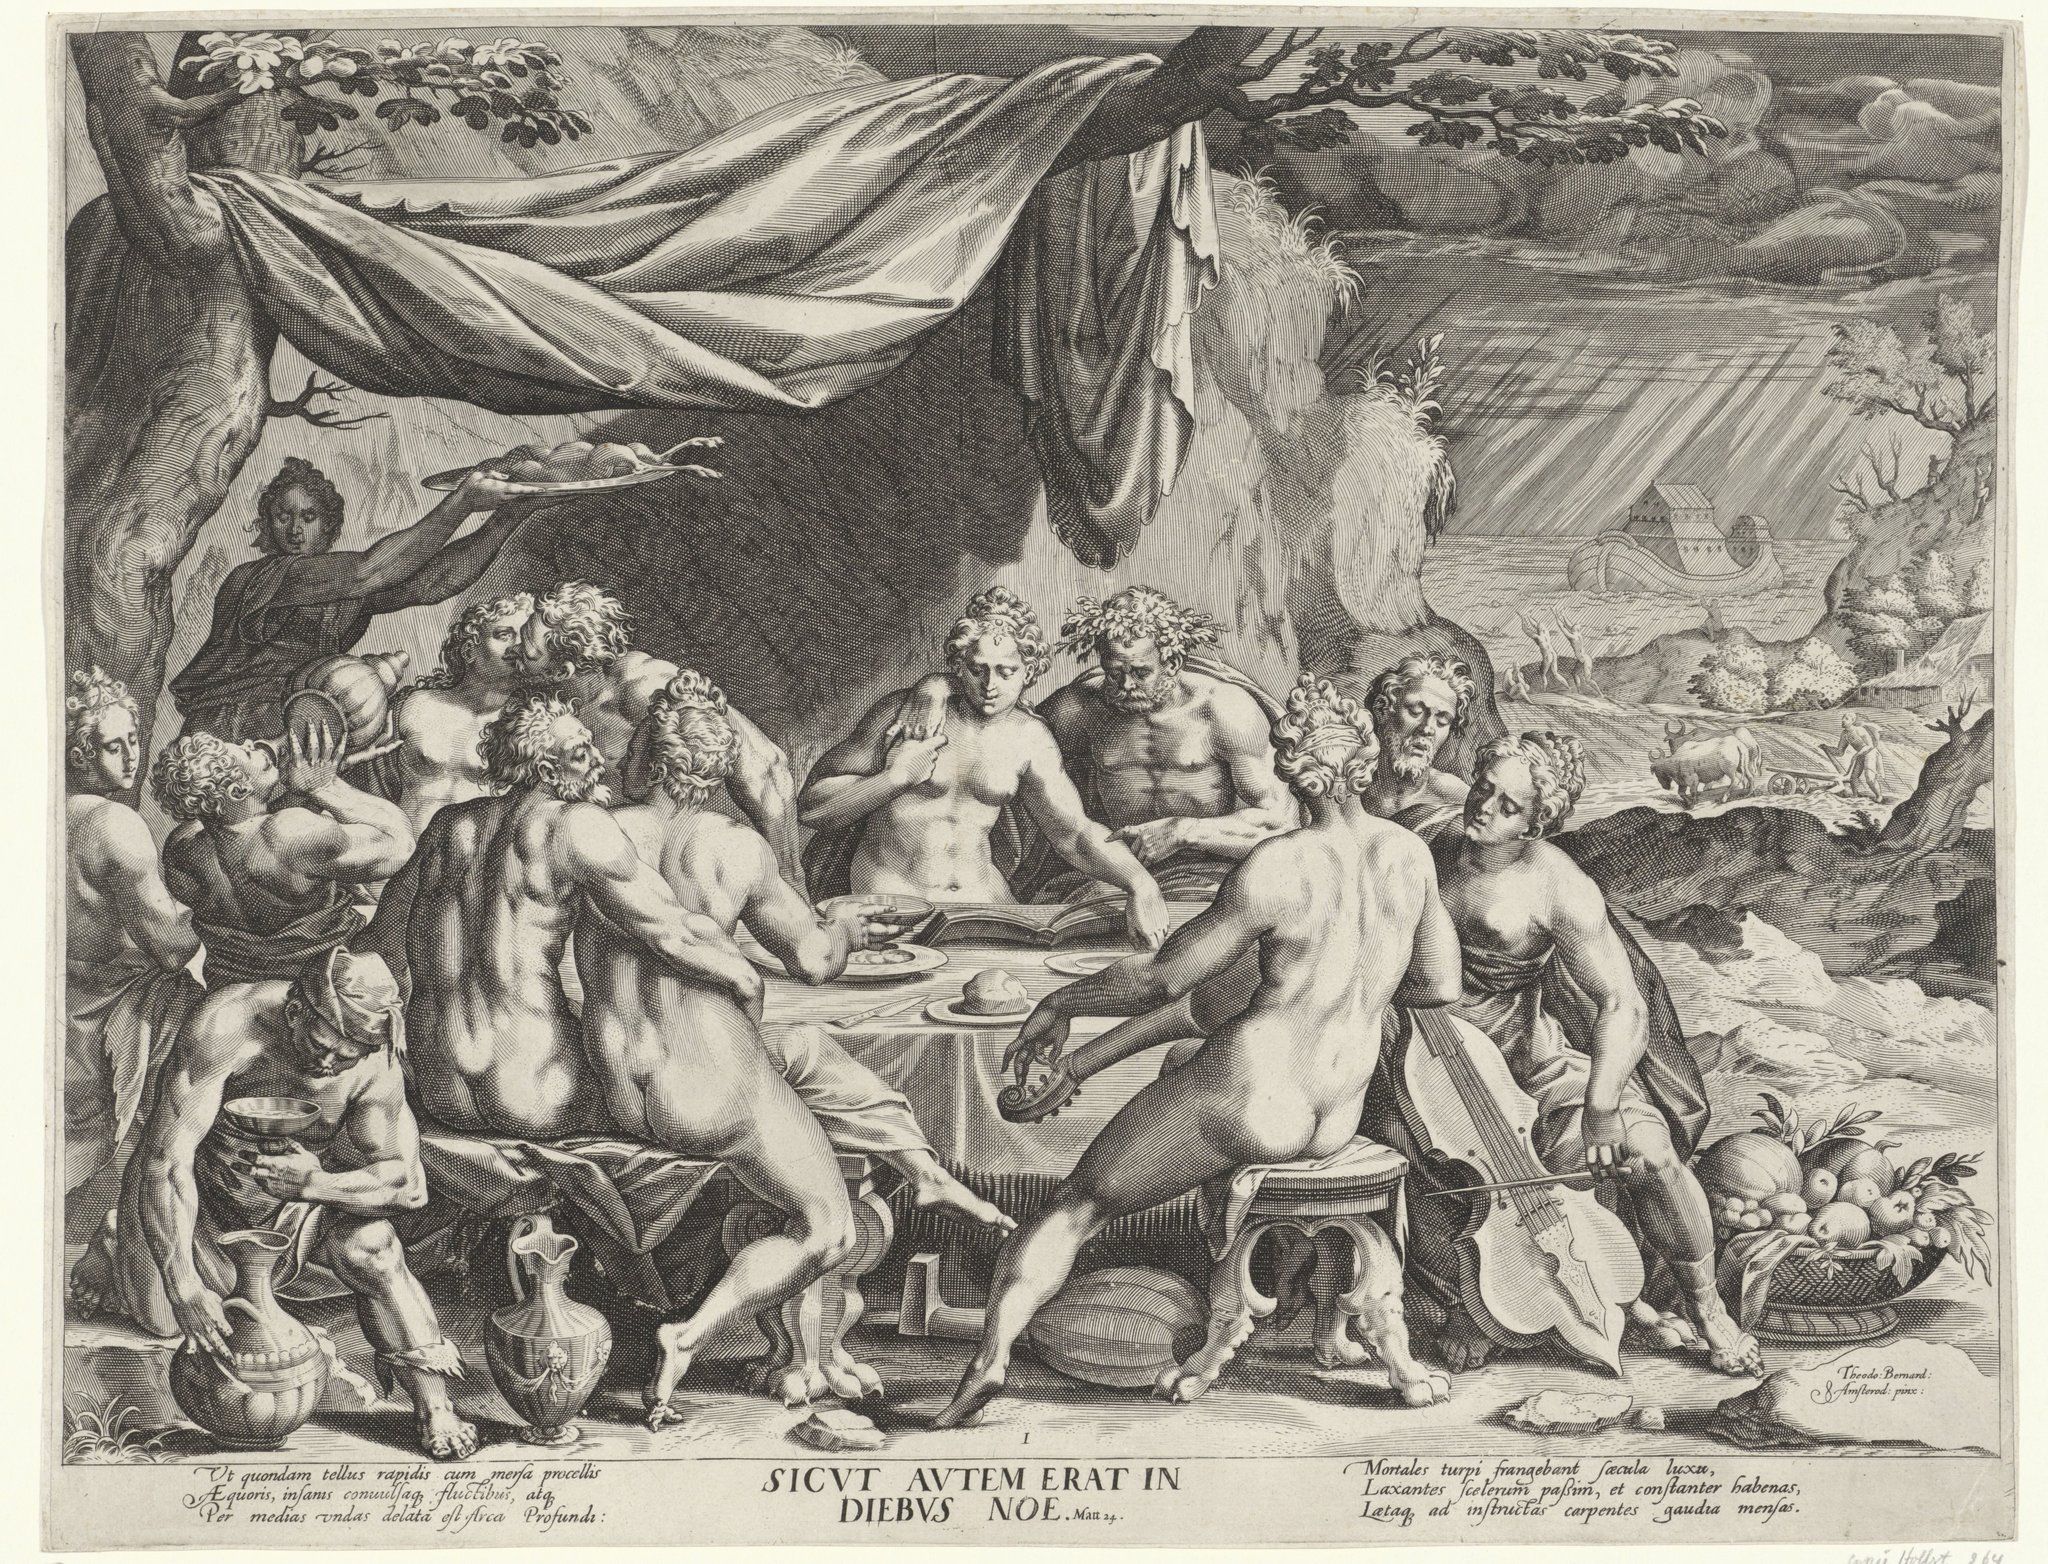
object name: print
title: De zondige mensheid vóór de zondvloed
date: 1601-1636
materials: paper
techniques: engraving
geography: amsterdam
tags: carousal, drinking-bout, orgy - cc - out of doors, the ark is floating on the waters, while life on earth is destroyed ~ story of noah, the wickedness of mankind; the wicked are usually shown feasting and revelling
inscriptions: collector's mark: Lugt 240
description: Een groep naakte mensen aan een gedekte tafel in de open lucht. Ze feesten, maken muziek, eten en plegen ontucht. Rechtsachter de zondvloed met de ark. De prent heeft een Latijns onderschrift met uitleg.